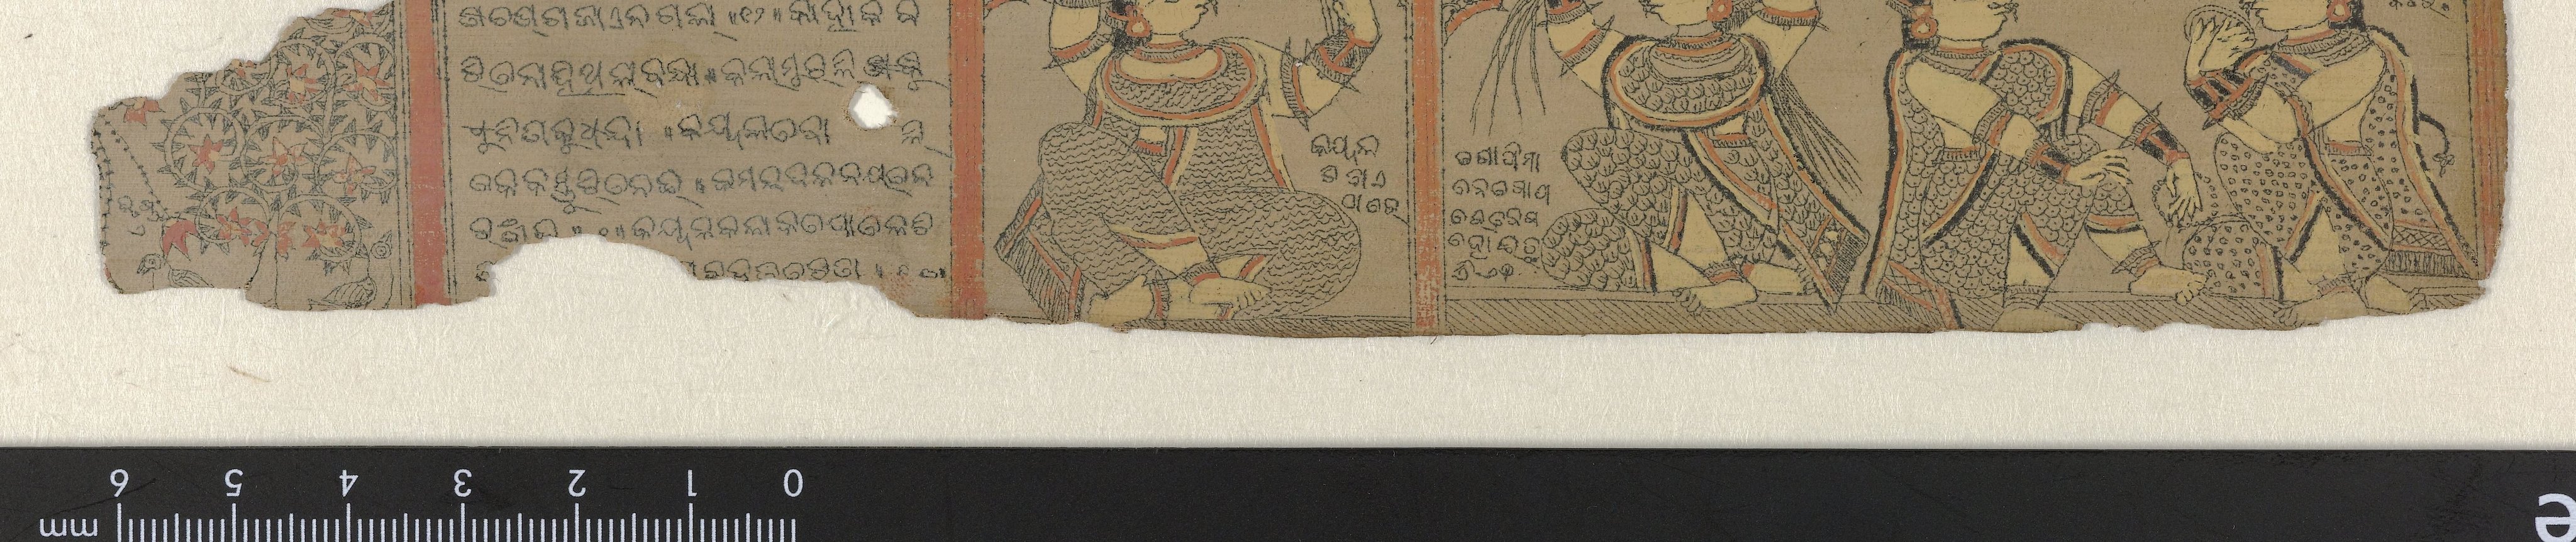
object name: drawing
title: Twee paneeltjes met een dame die haar toilet maakt en een drietal dames die zich optutten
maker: Anonymous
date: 1700-1800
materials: leaf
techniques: brush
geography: odisha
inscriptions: inscription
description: Links op het palmblad een stukje met bloemranken, daarnaast een paneeltje met oud-Indiase schrifttekens en dan een paneeltje met een dame die toilet maakt; de rechterhelft van het blad bestaat uit een paneel met drie dames die zich optutten. Het stukje palmblad is in een blauw passepartout opgenomen zodat voor- en achterkant zichtbaar zijn.